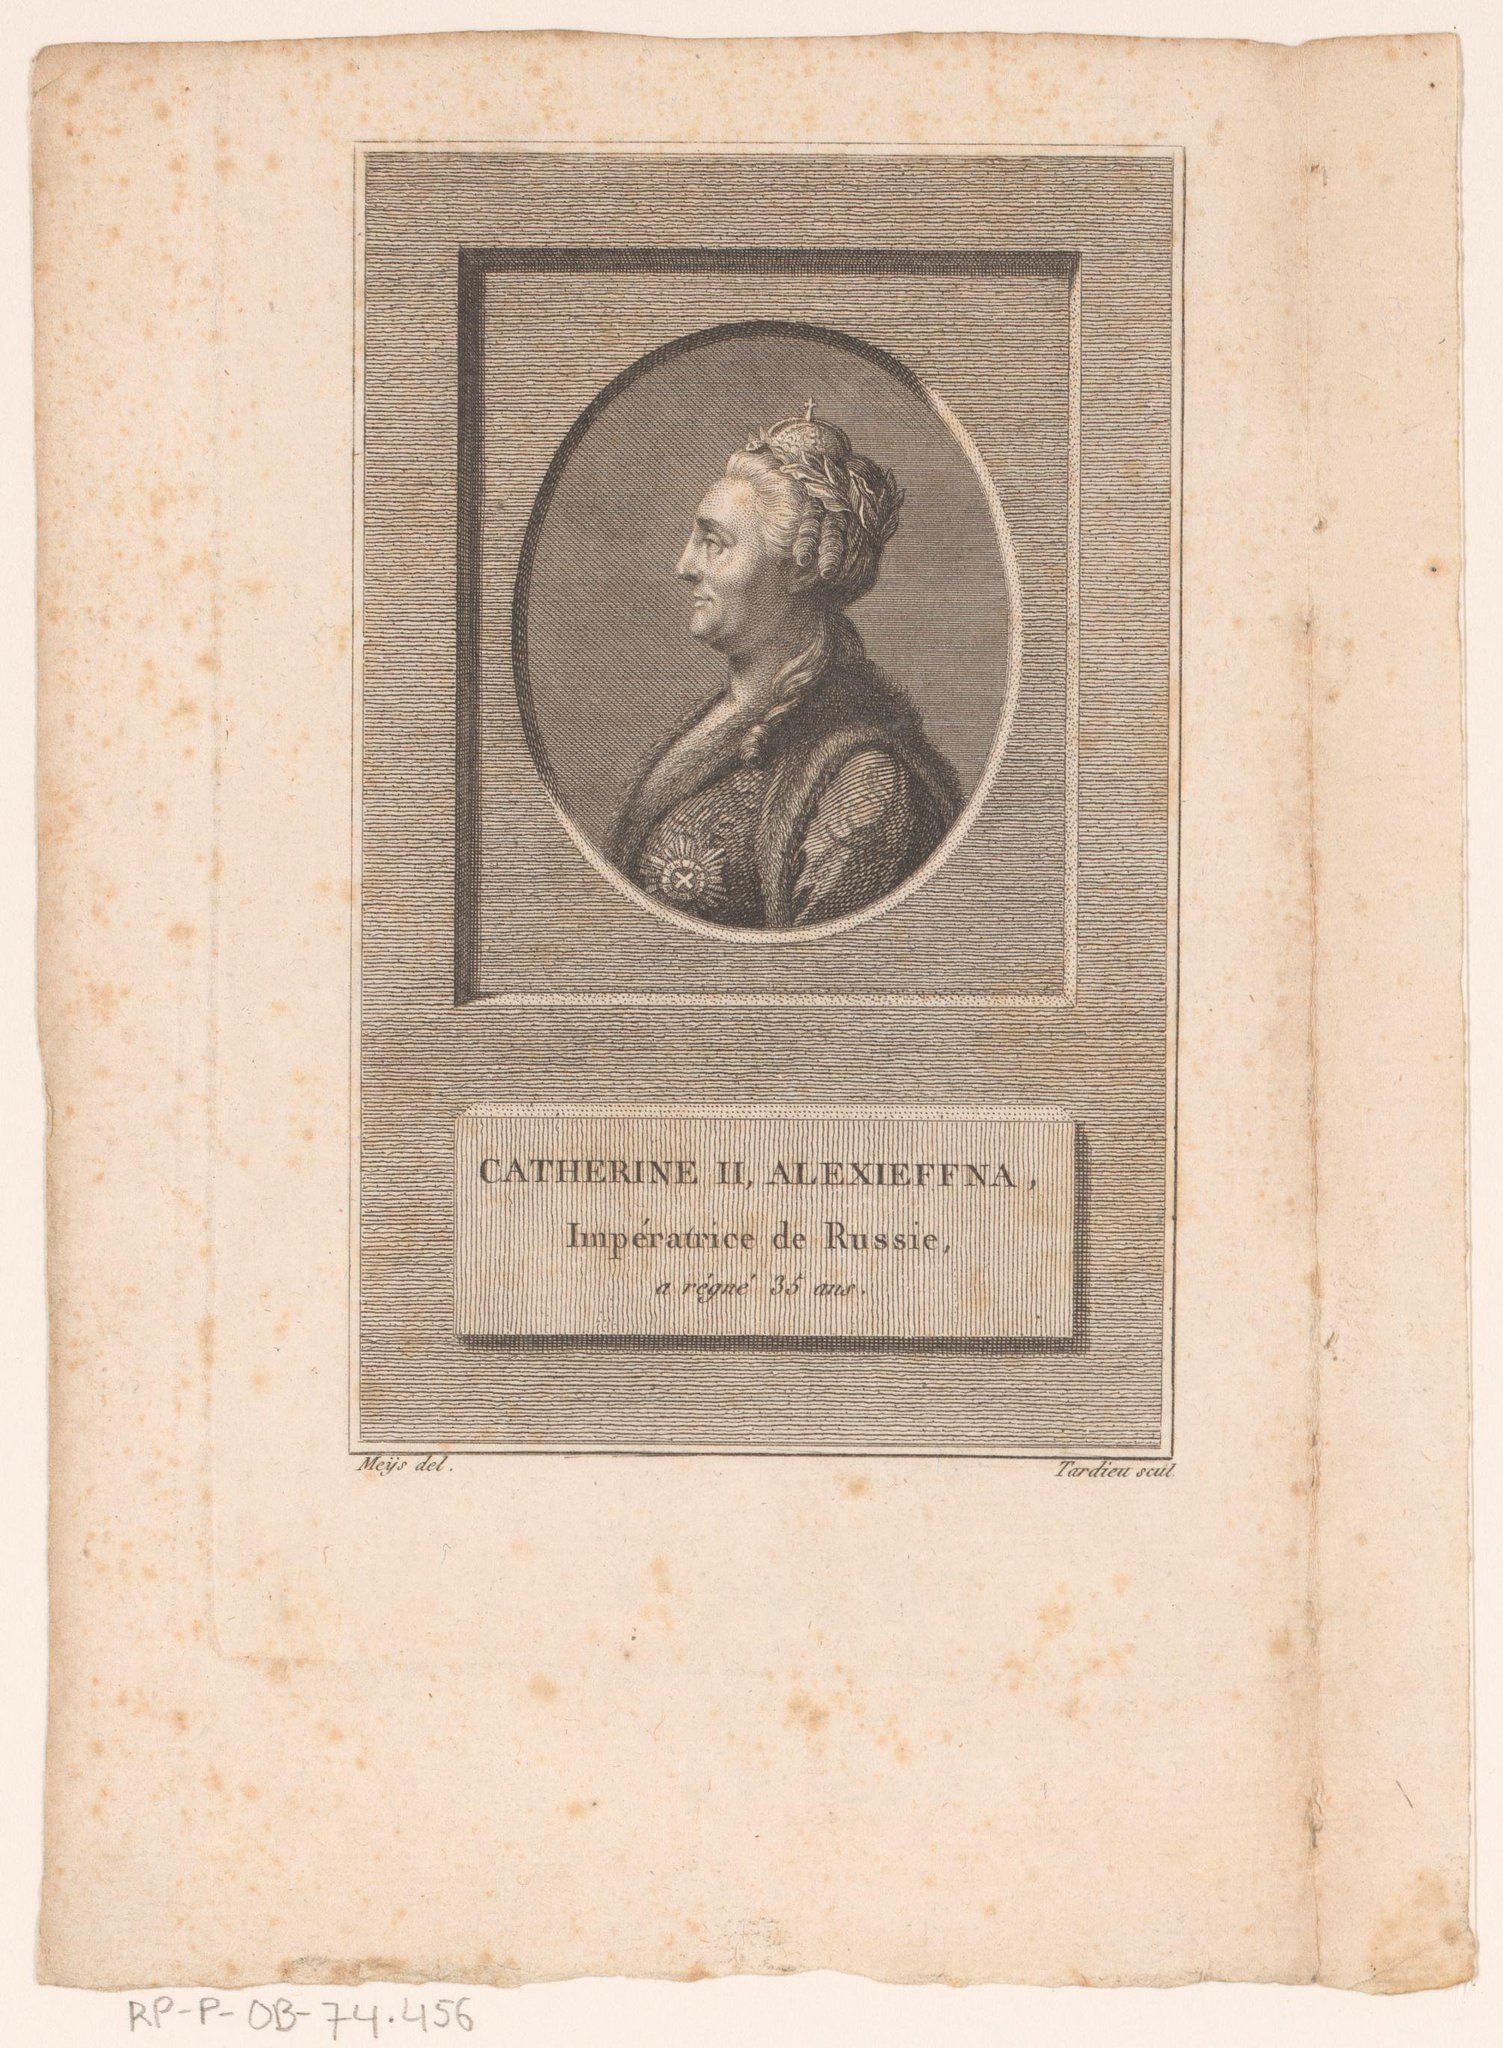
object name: print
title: Portret van tsarina Catharina de Grote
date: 1790-1844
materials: paper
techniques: engraving, etching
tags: catharina de grote, historical persons, emperor - bb - female ruler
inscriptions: collector's mark: Lugt 2228